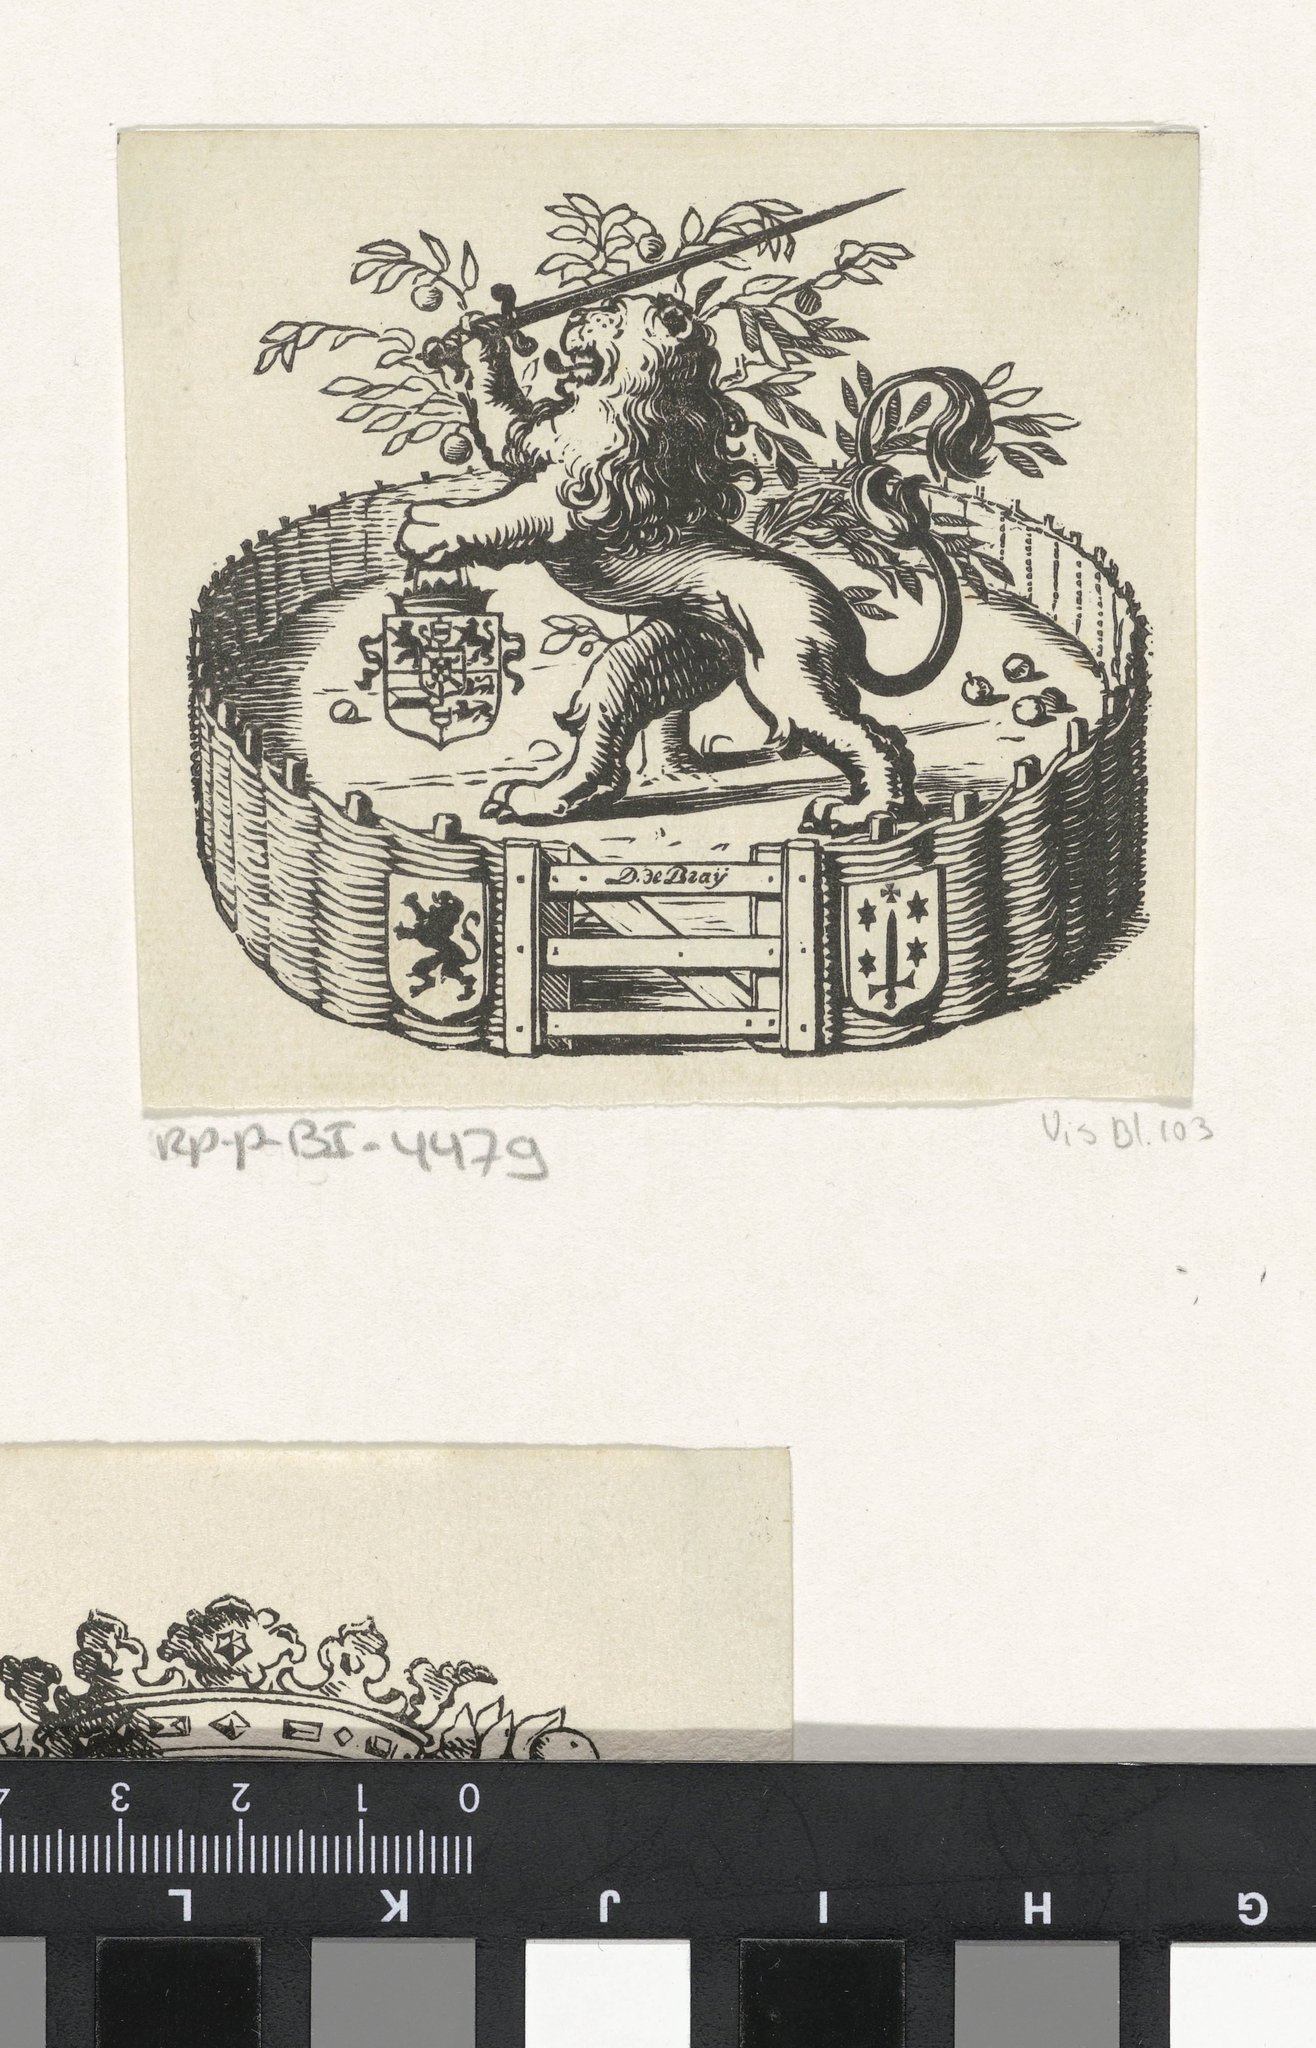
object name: print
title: Emblematisch wapen van de provincie Holland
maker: dirck de bray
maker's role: draughtsman, painter, print maker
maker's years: 1625-1694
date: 1635-1694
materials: paper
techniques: woodcut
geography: netherlands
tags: coat of arms (as symbol of the state, etc.) (+ province; provincial), holland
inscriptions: collector's mark: Lugt 2228